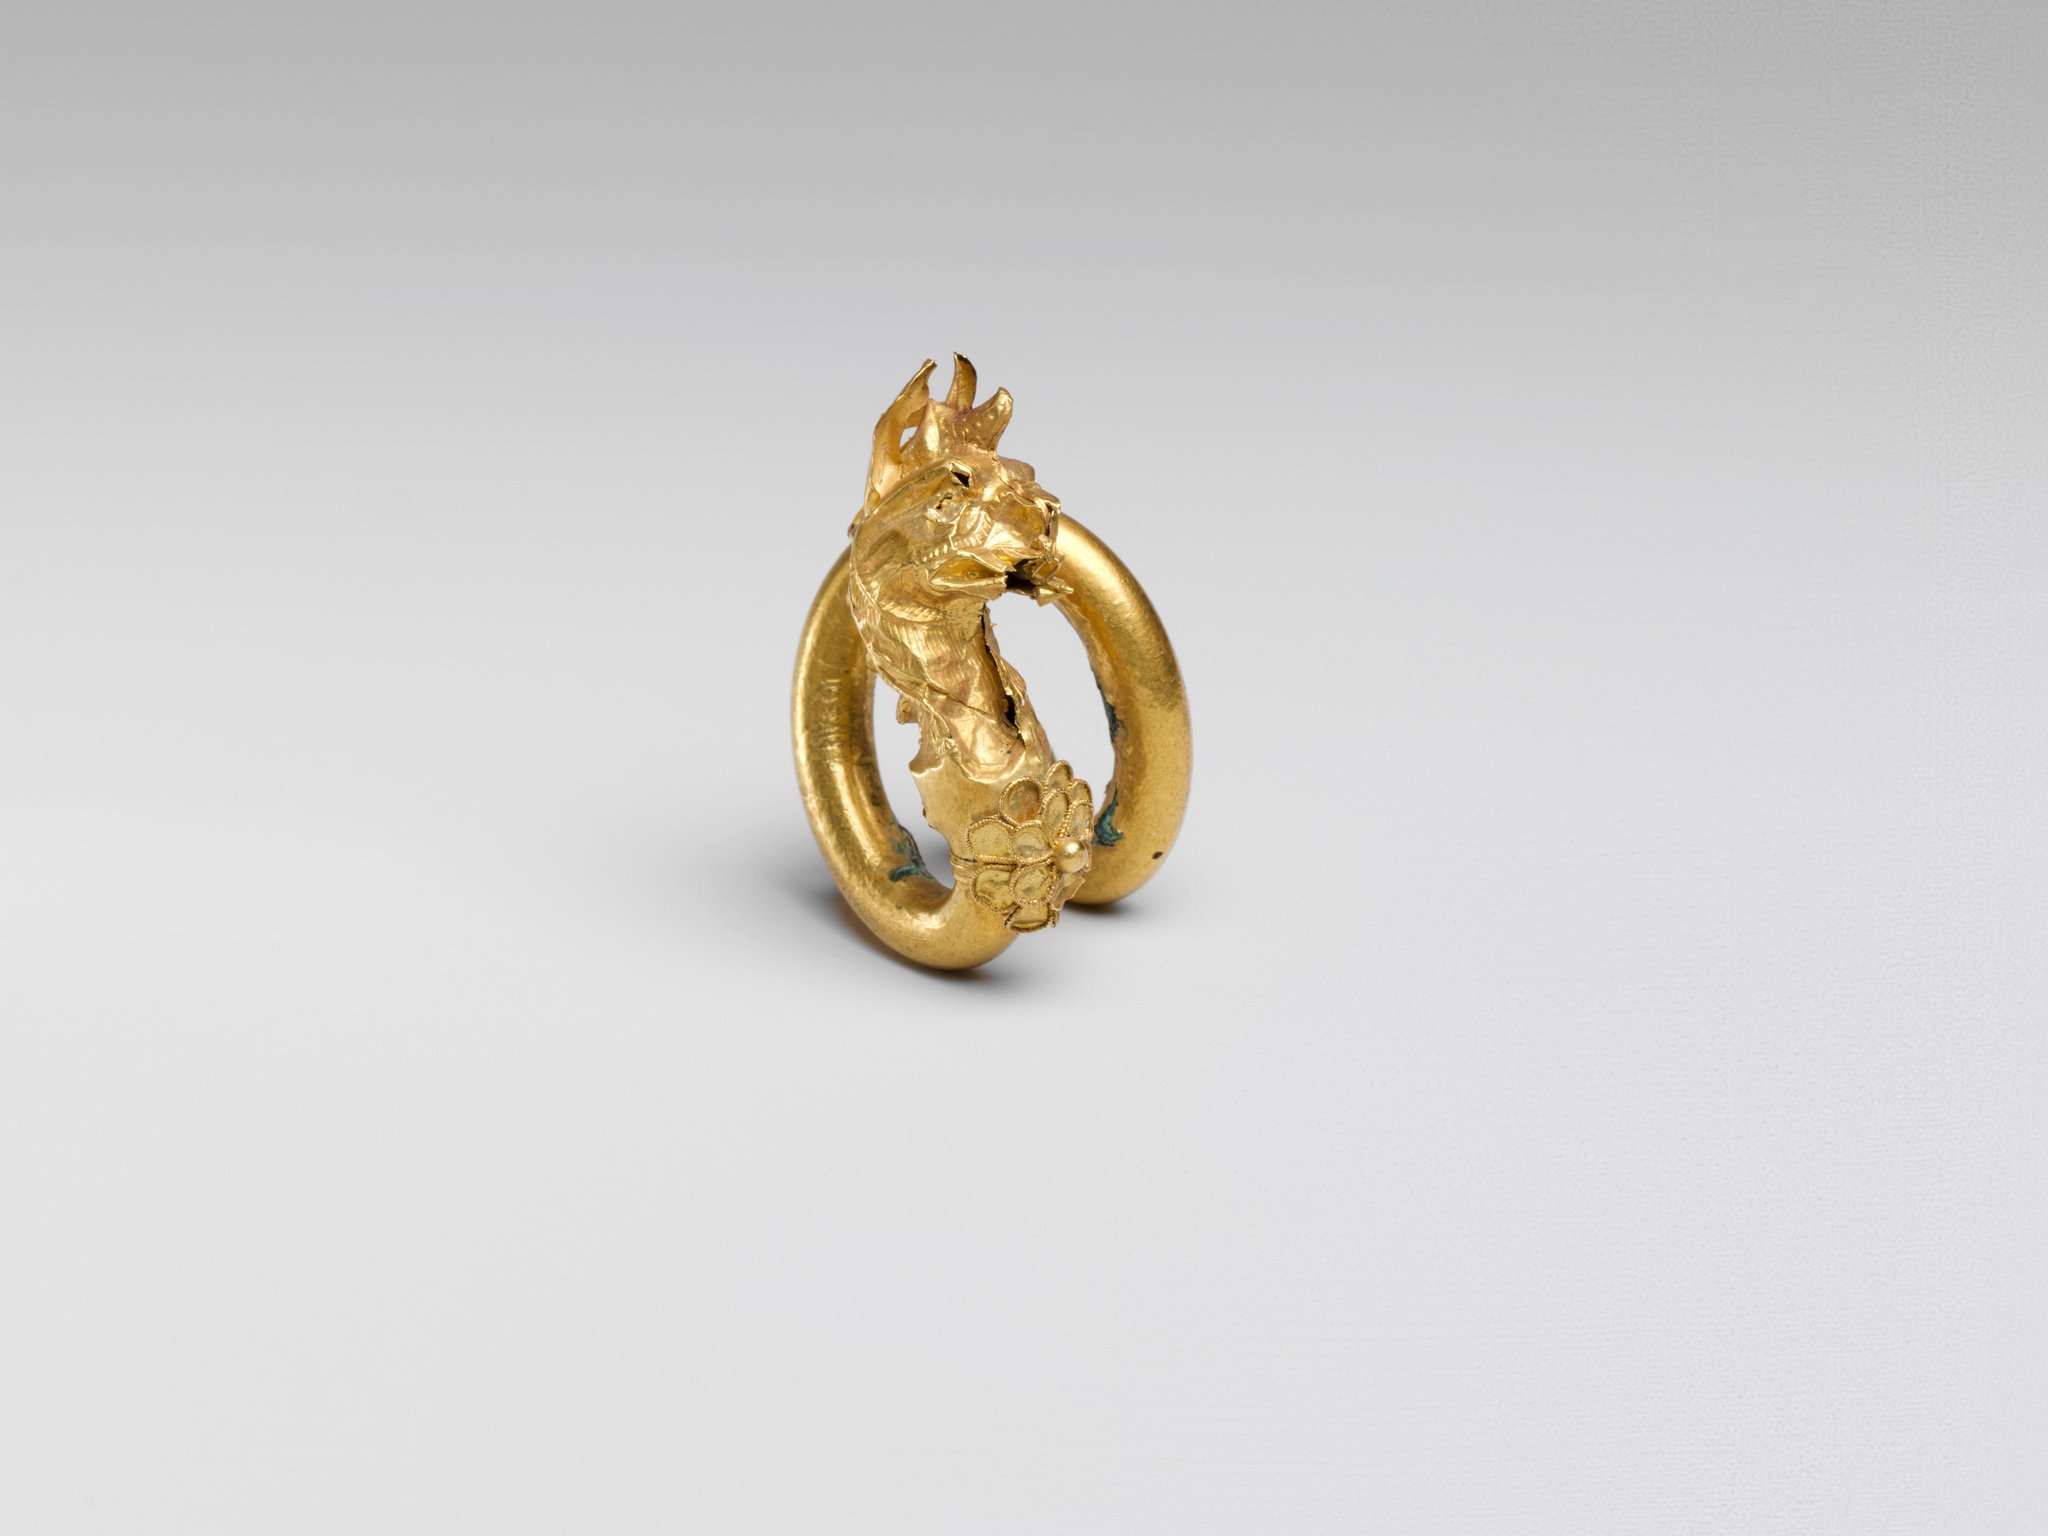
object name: earring or spiral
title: Gilt bronze spiral with griffin terminal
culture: cypriot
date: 400-350 BCE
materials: bronze, gold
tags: griffins